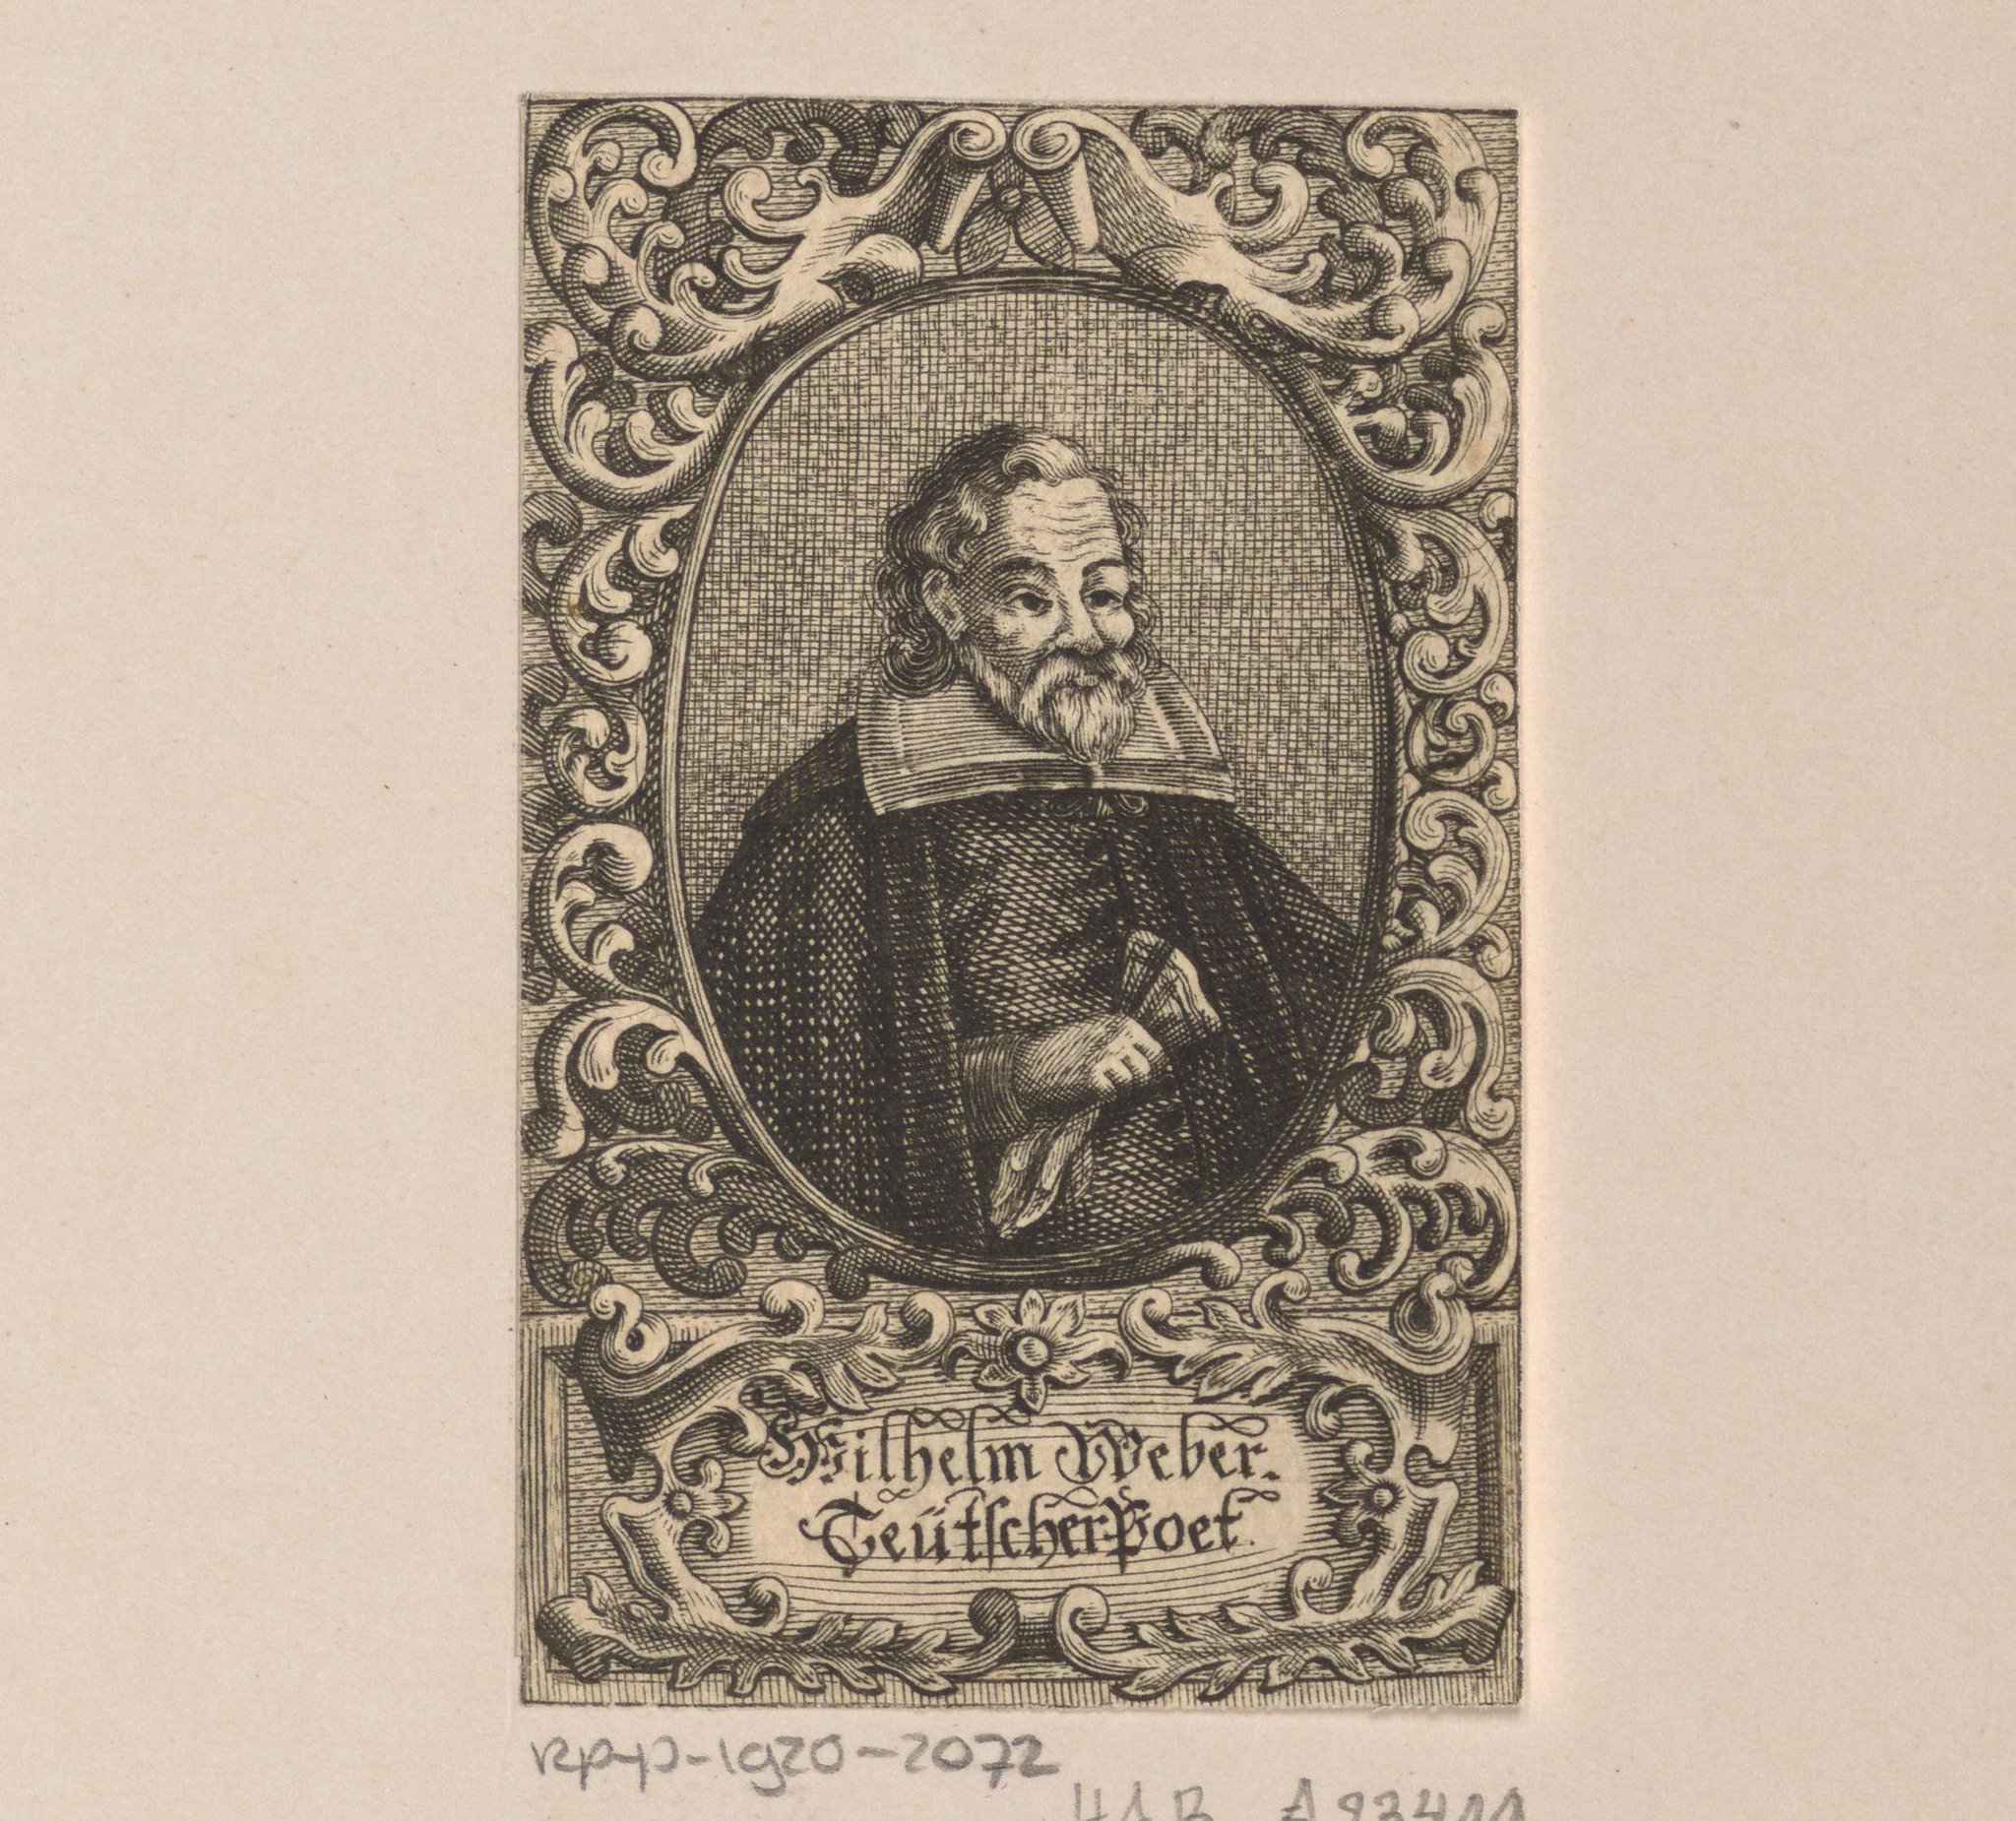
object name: print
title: Portret van Wilhelm Weber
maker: Anonymous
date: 1650-1690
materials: paper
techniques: engraving, etching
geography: germany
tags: historical persons, writer, poet, author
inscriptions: collector's mark: Lugt 2228